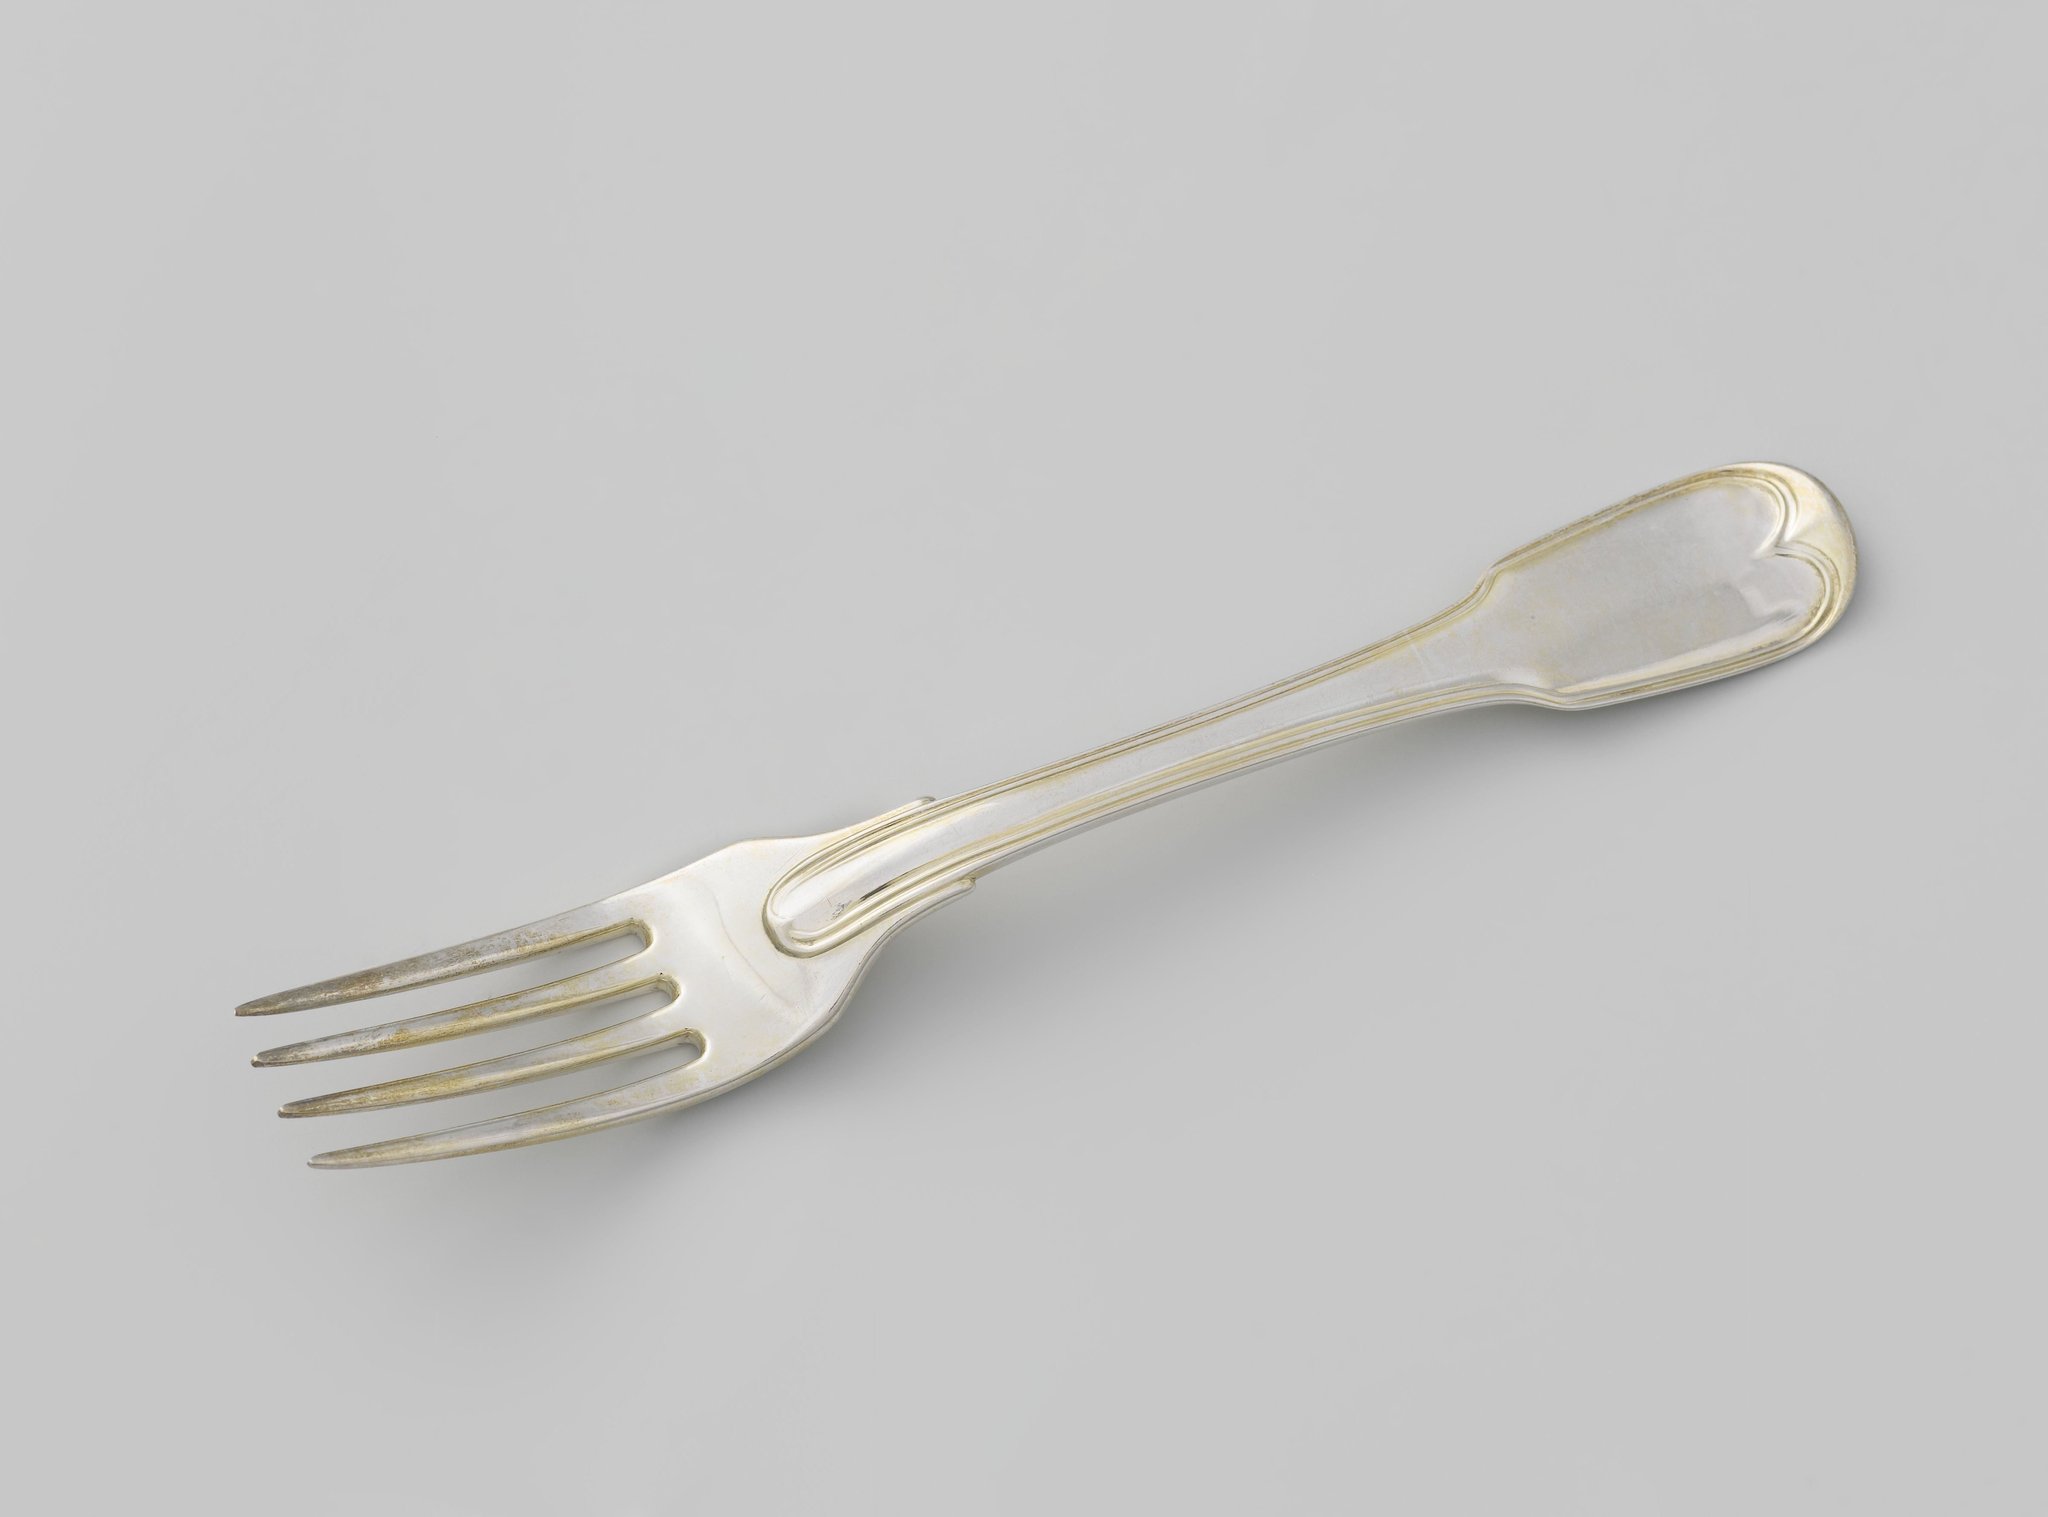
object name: fork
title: Vork met het helmteken Clifford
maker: hendrik helweg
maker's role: silversmith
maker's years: 1802-1858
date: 1832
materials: silver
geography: amsterdam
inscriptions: hallmark: ‘Minervakop met A (keurkamer Amsterdam)’, maker's mark: ‘HH onder anker in vierkant’, alloy mark: ‘leeuw 1ste gehalte’, date letter: ‘X (=1806)’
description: De viertandige vork is aan zowel boven- als onderzijde door middel van enkel lof verbonden met de platte, gebogen steel, die zich verbreedt naar het spatelvormige uiteinde. Boven- en onderzijde van de steel worden omgeven door een dubbele filetrand, die bij het uiteinde ingezwenkt is. Op de onderzijde van de spatel is het helmteken Clifford gegraveerd.